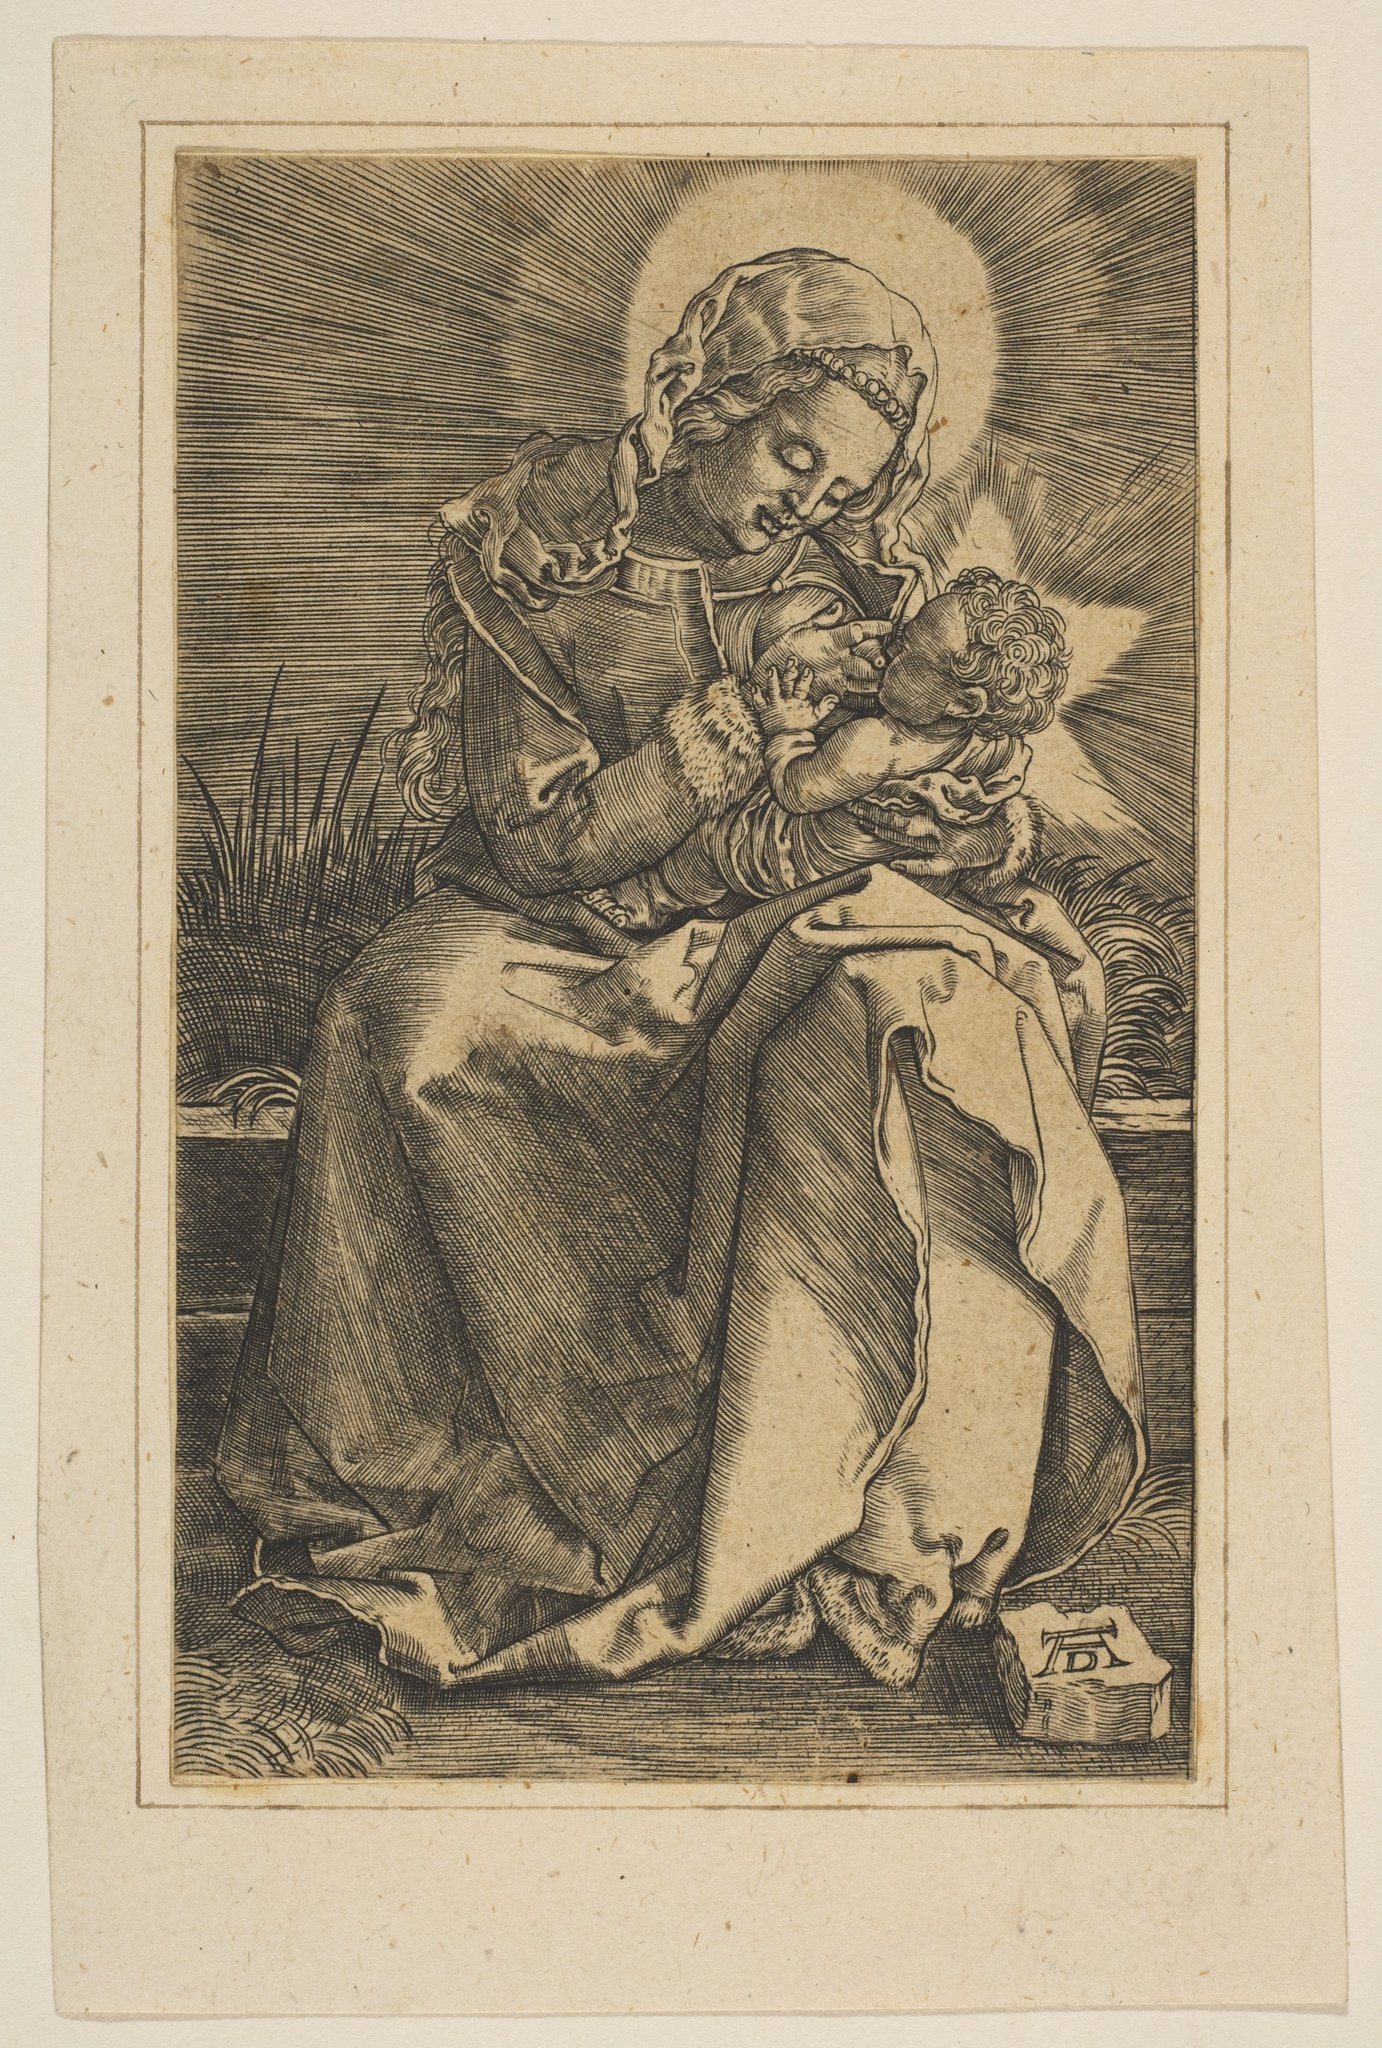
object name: print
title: The Virgin Nursing the Christ Child, copy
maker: albrecht dürer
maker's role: artist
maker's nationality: german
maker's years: 1471-1528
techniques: engraving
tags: christ,virgin mary